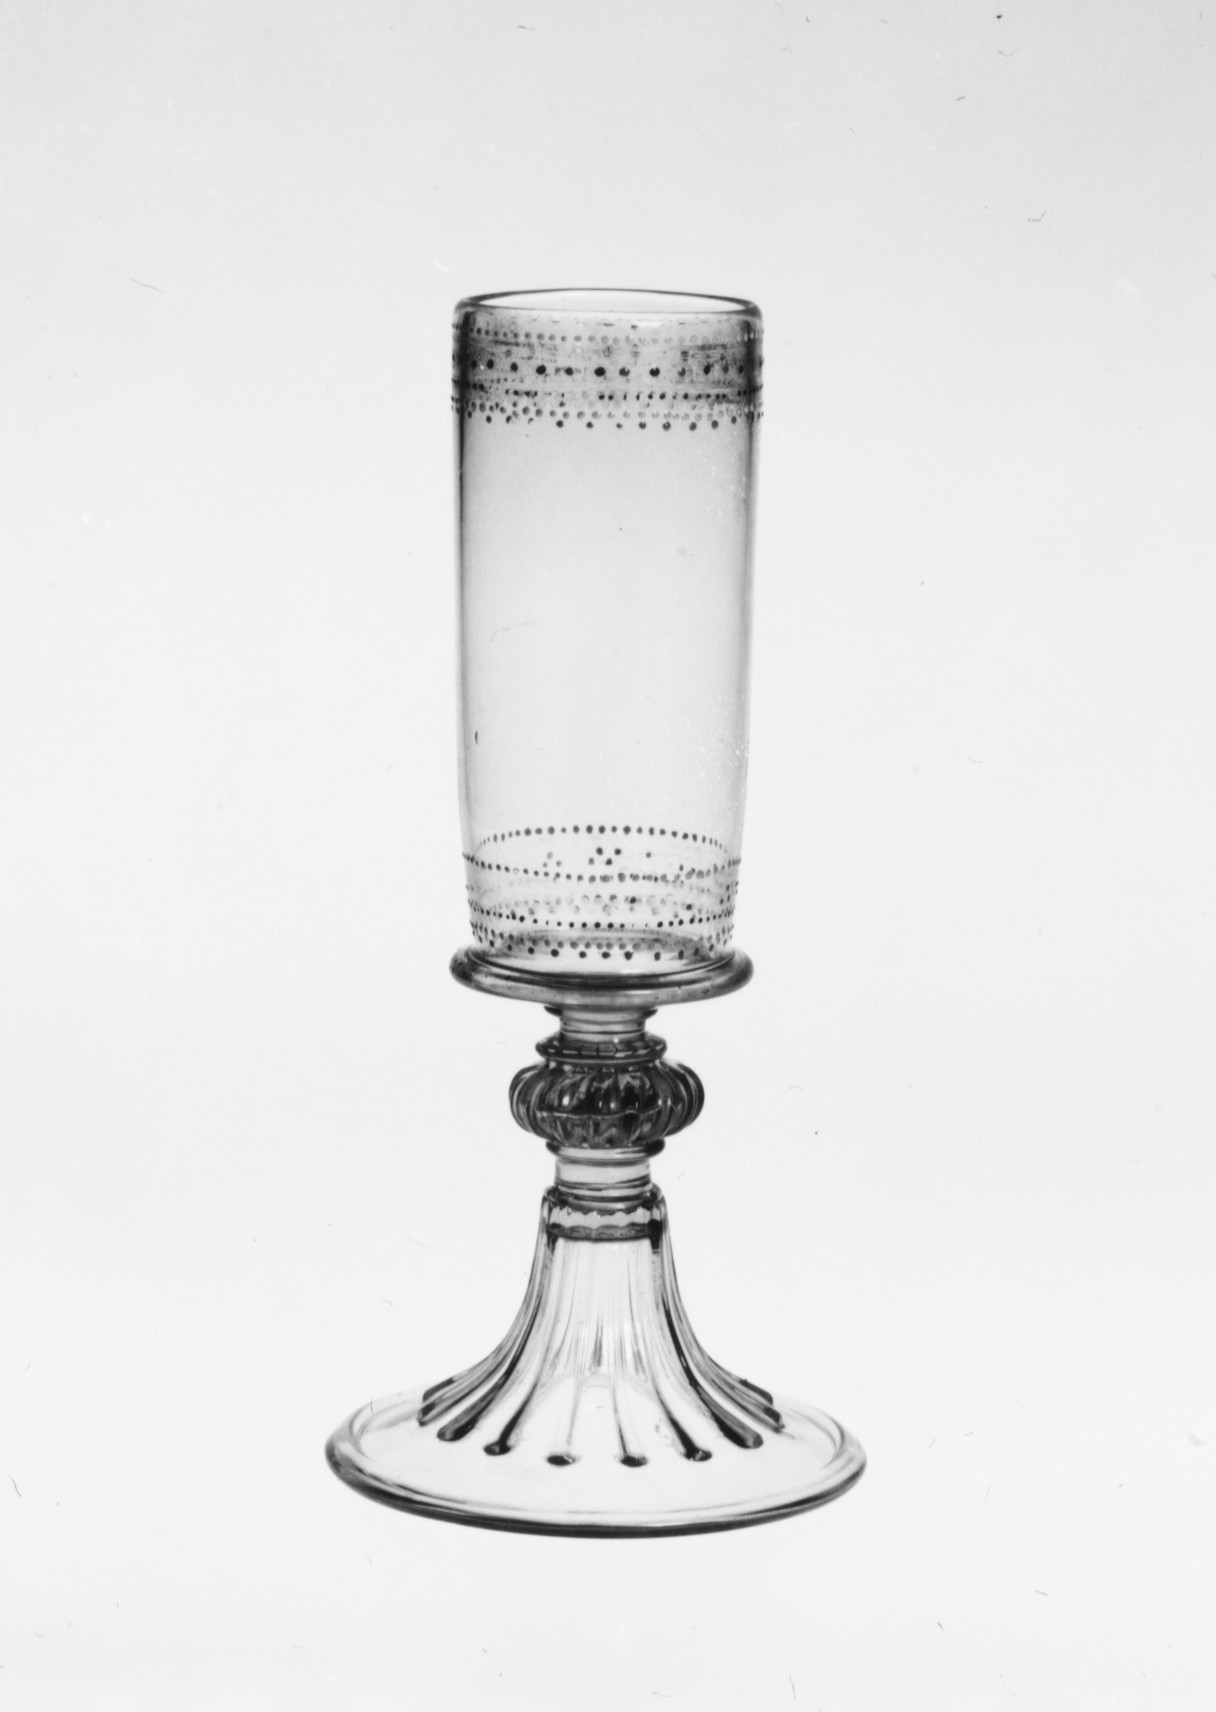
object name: goblet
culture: italian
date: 1500-1525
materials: gilt, glass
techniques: glassblowing, enamel, molding